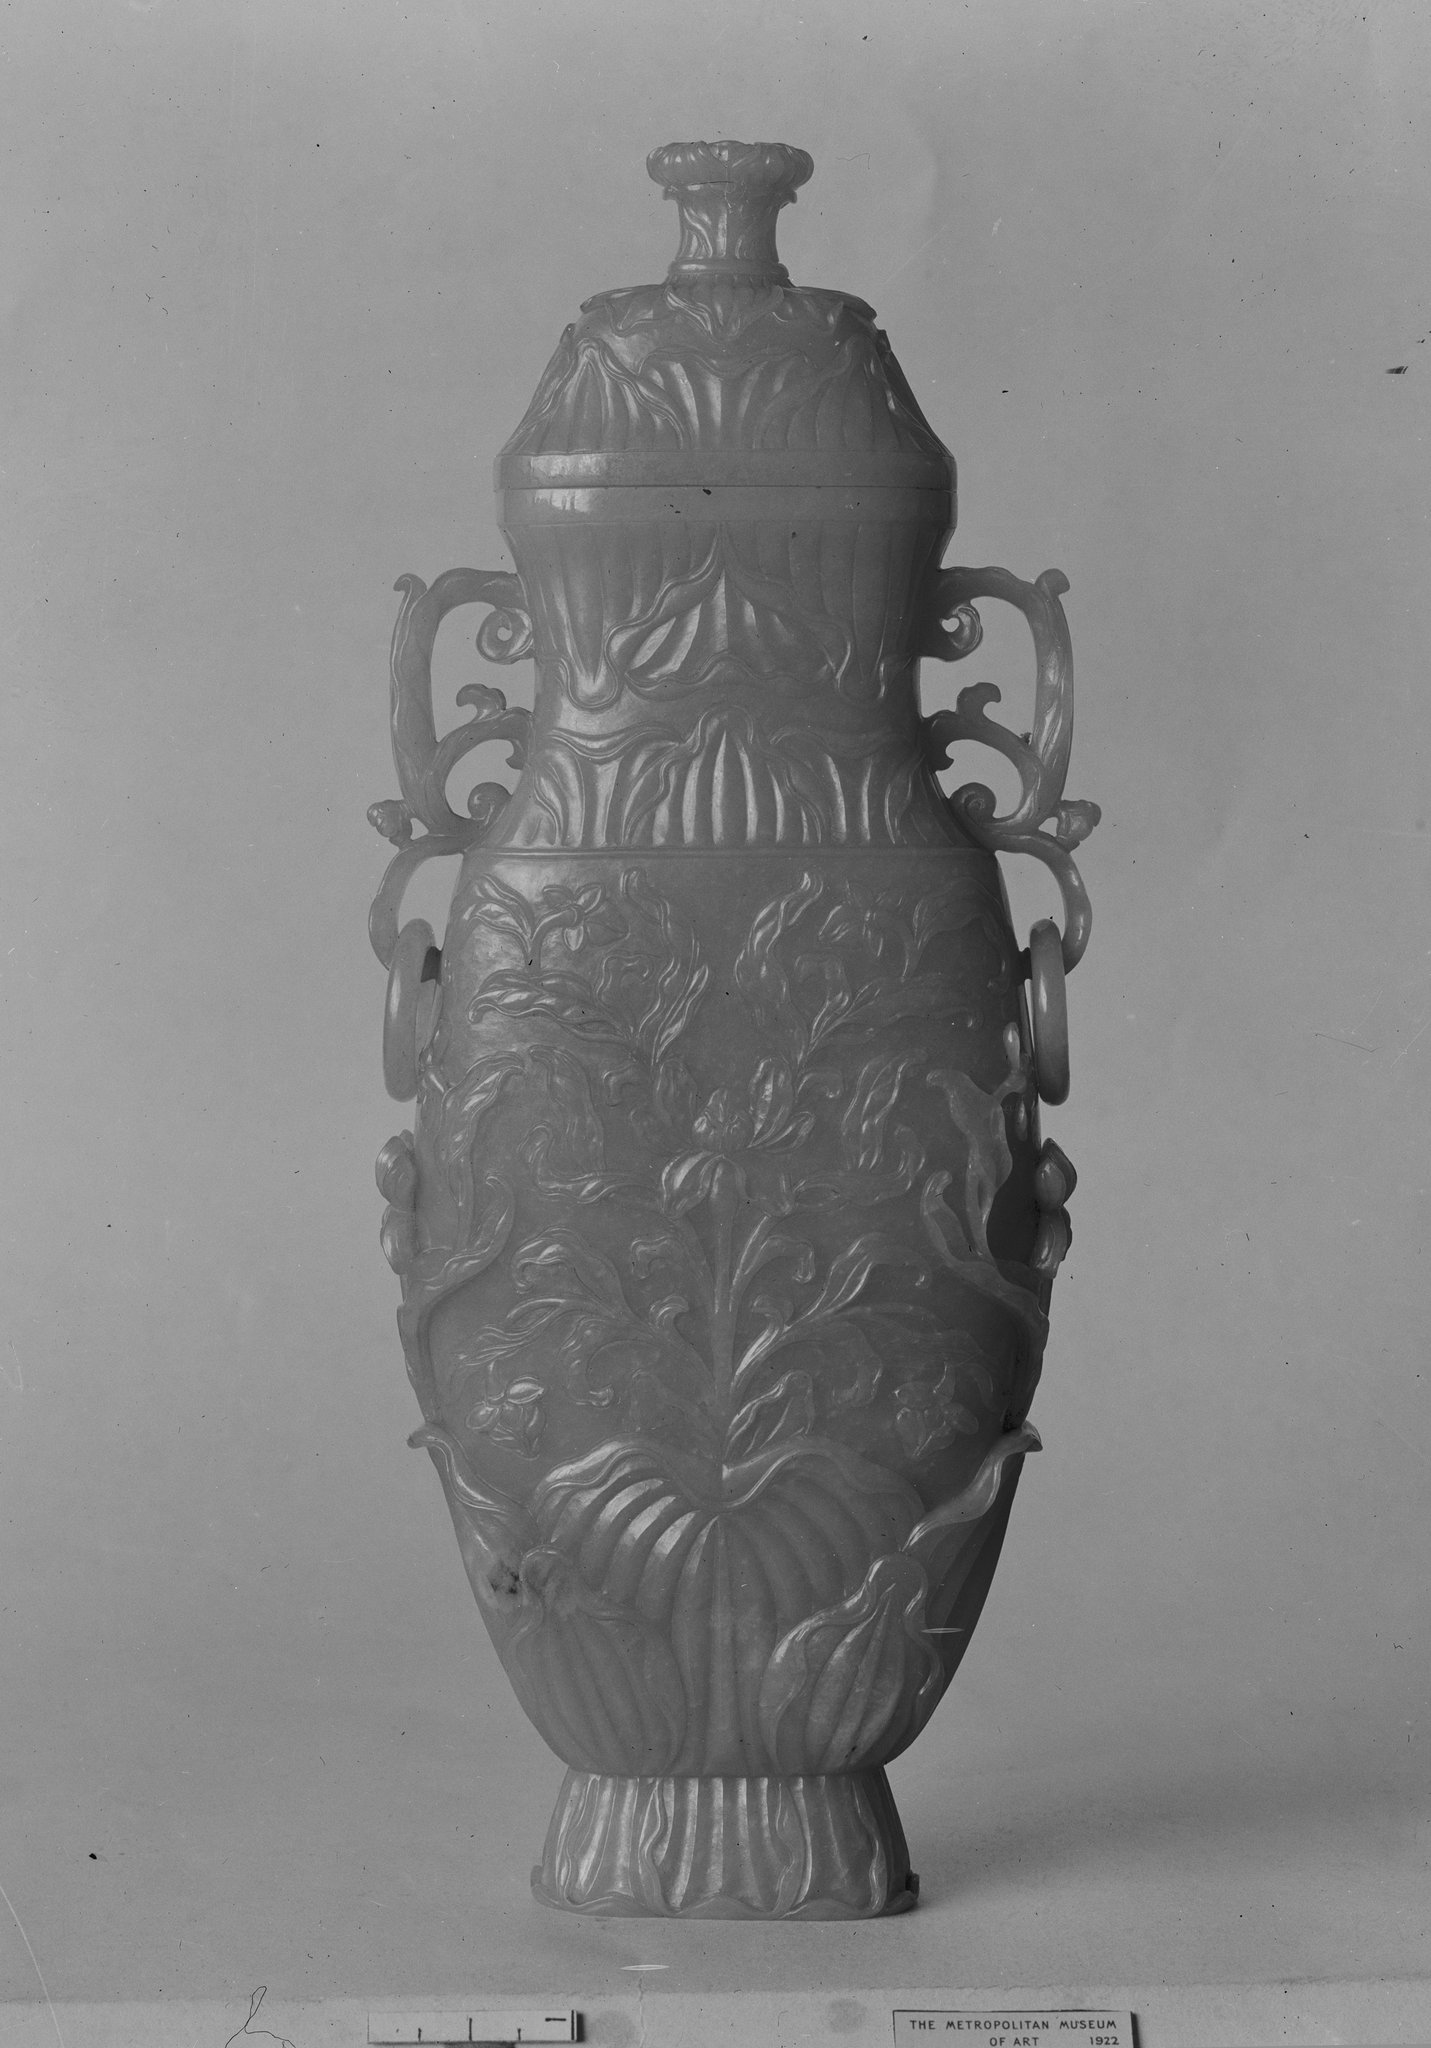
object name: covered vase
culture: chinese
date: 1736-1795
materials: jade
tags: flowers,leaves